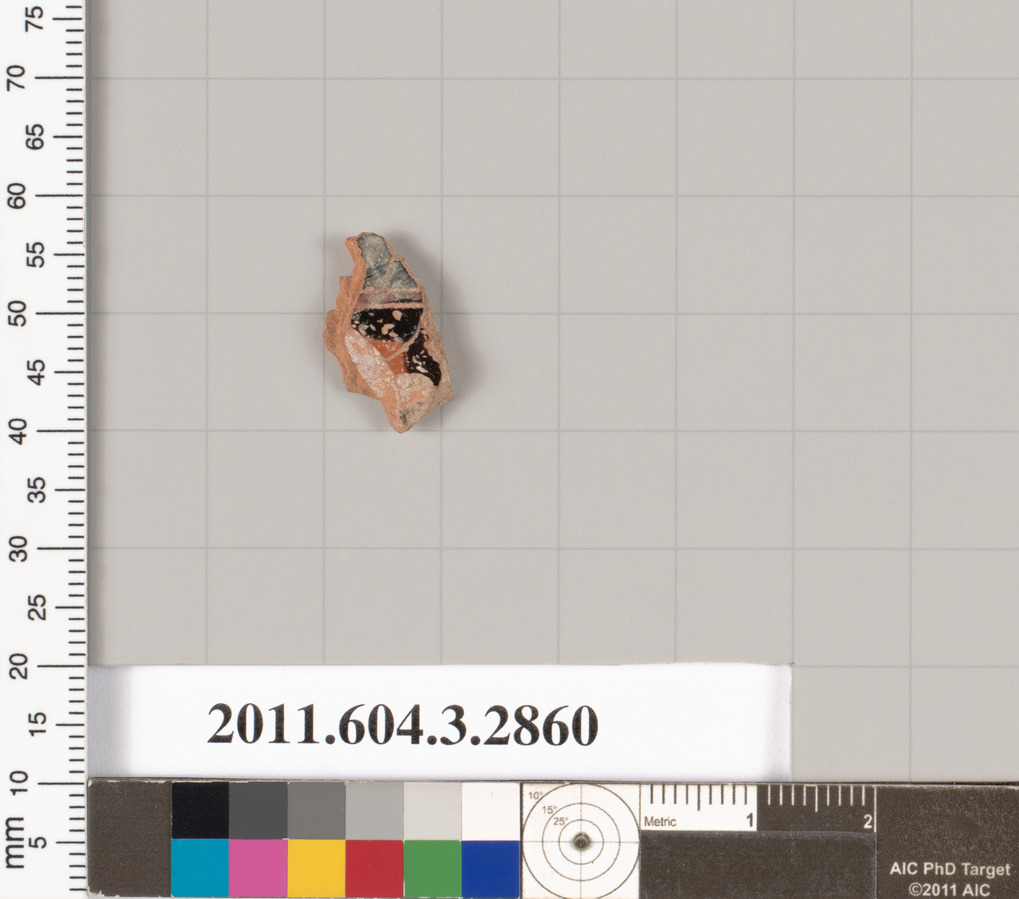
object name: undetermined closed shape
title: Terracotta fragment of a closed shape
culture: greek, attic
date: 534-468 BCE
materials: terracotta